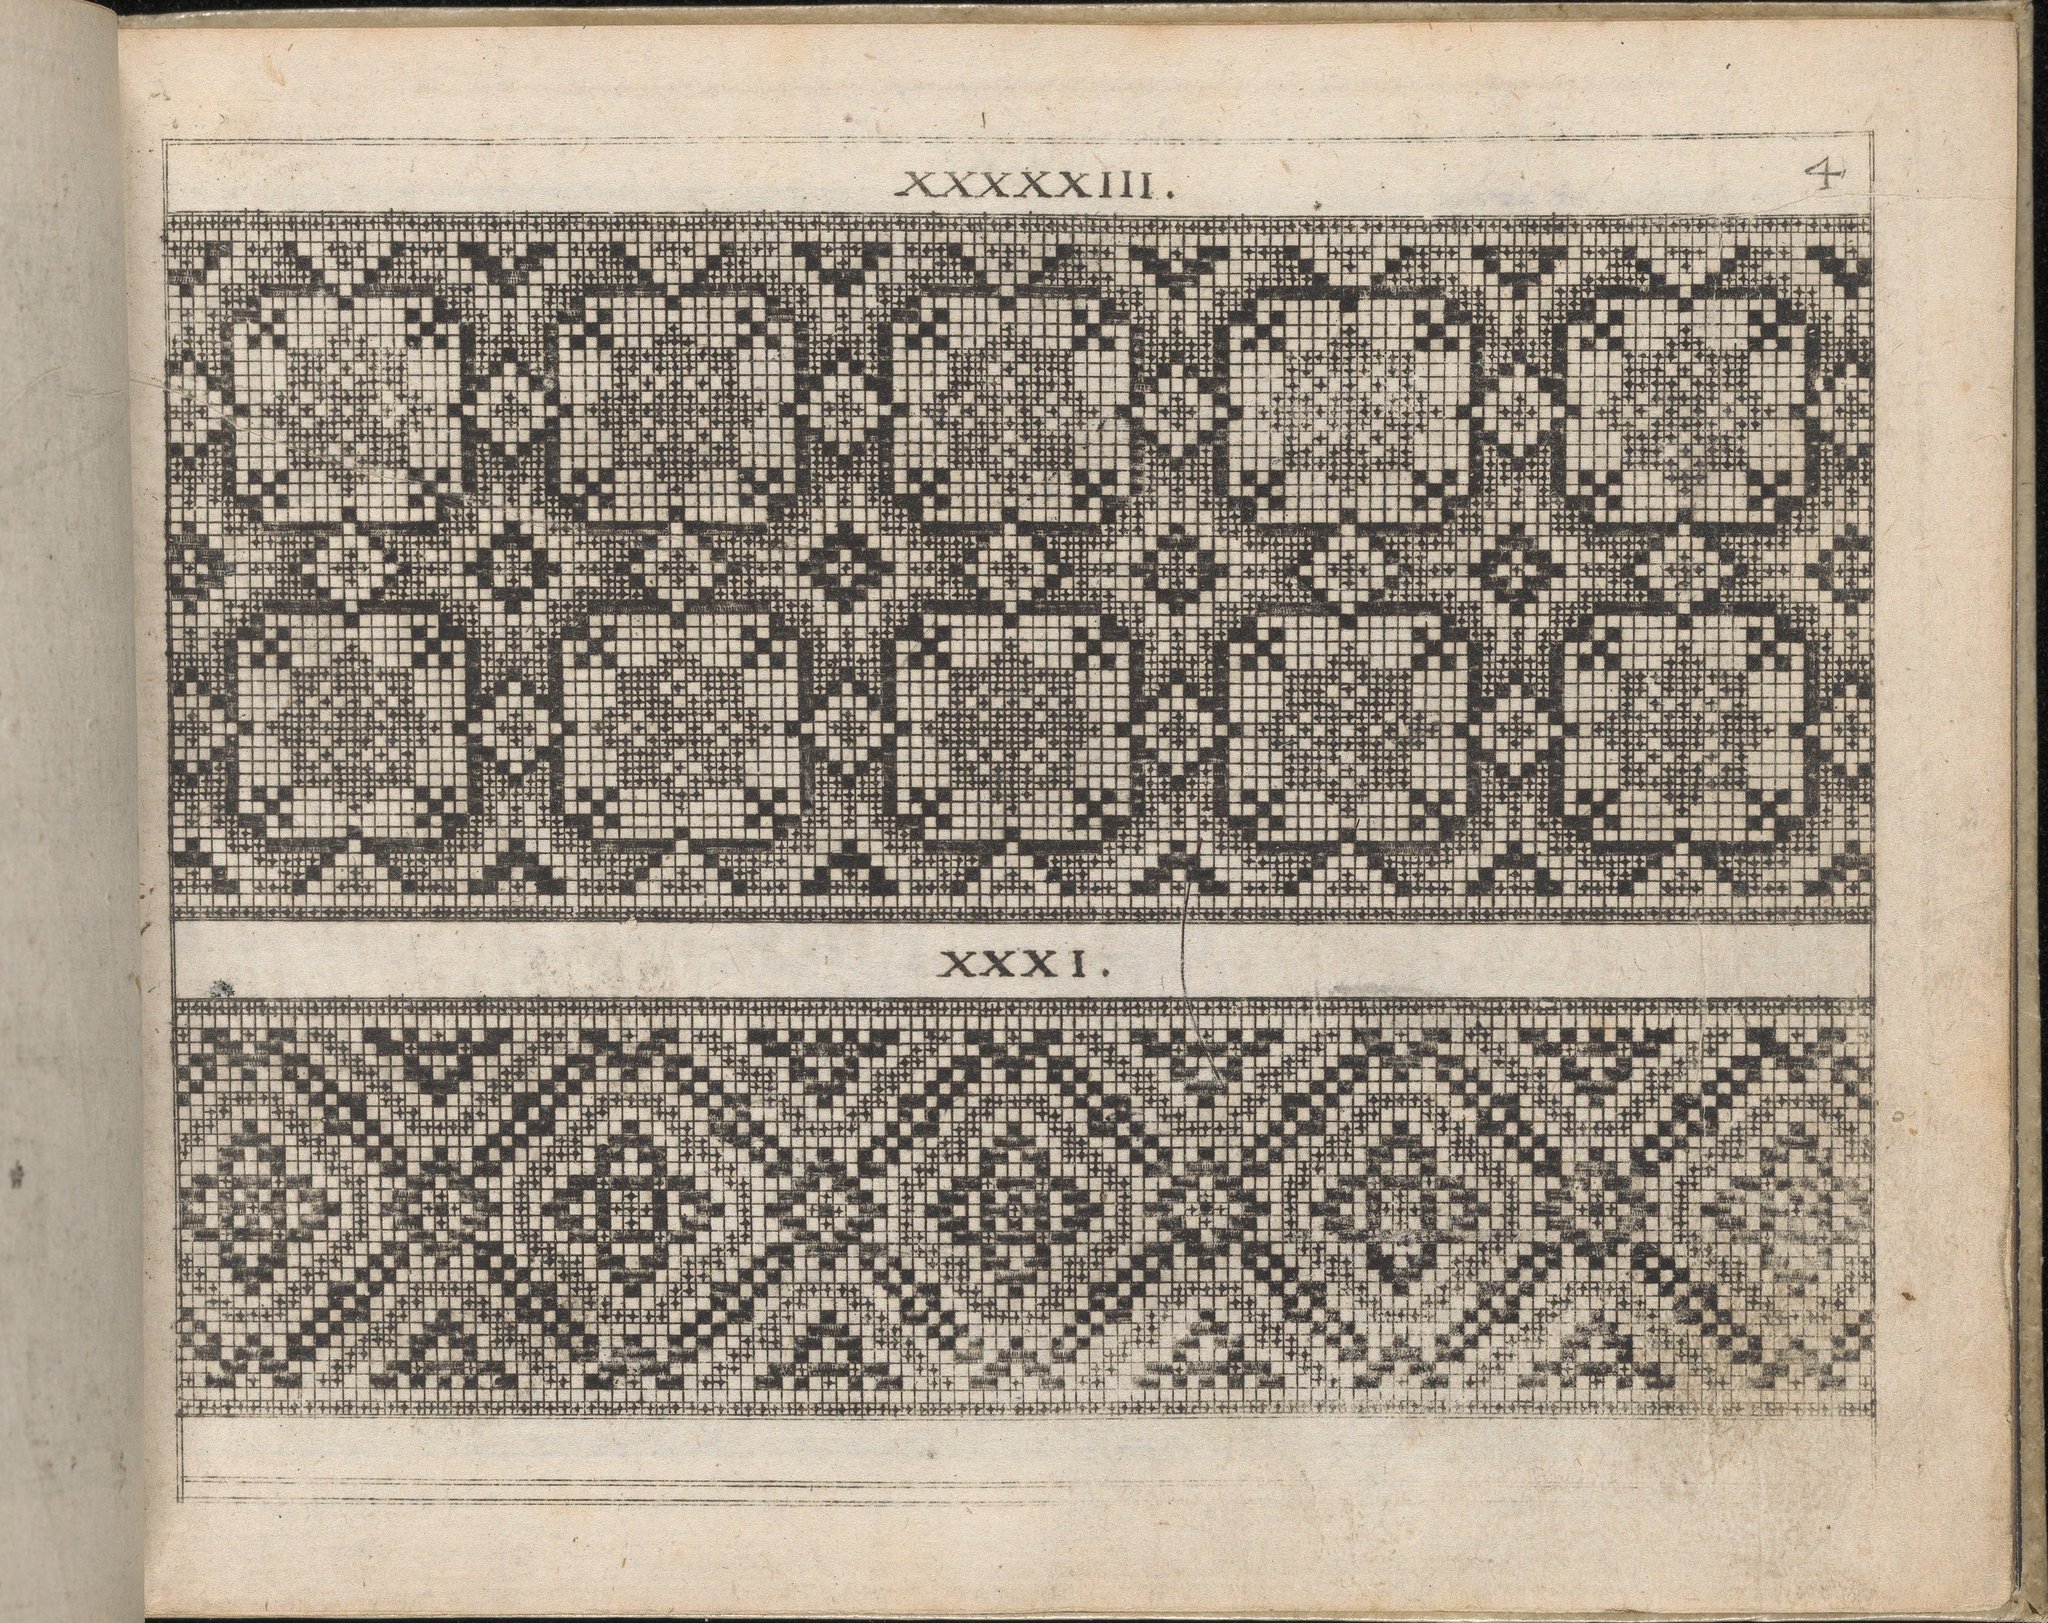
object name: book print ornament architecture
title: Newes Modelbuch in Kupffer (Page 13r)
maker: johann sibmacher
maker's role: artist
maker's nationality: german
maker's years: 1590-1611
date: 1604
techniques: etching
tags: ornament